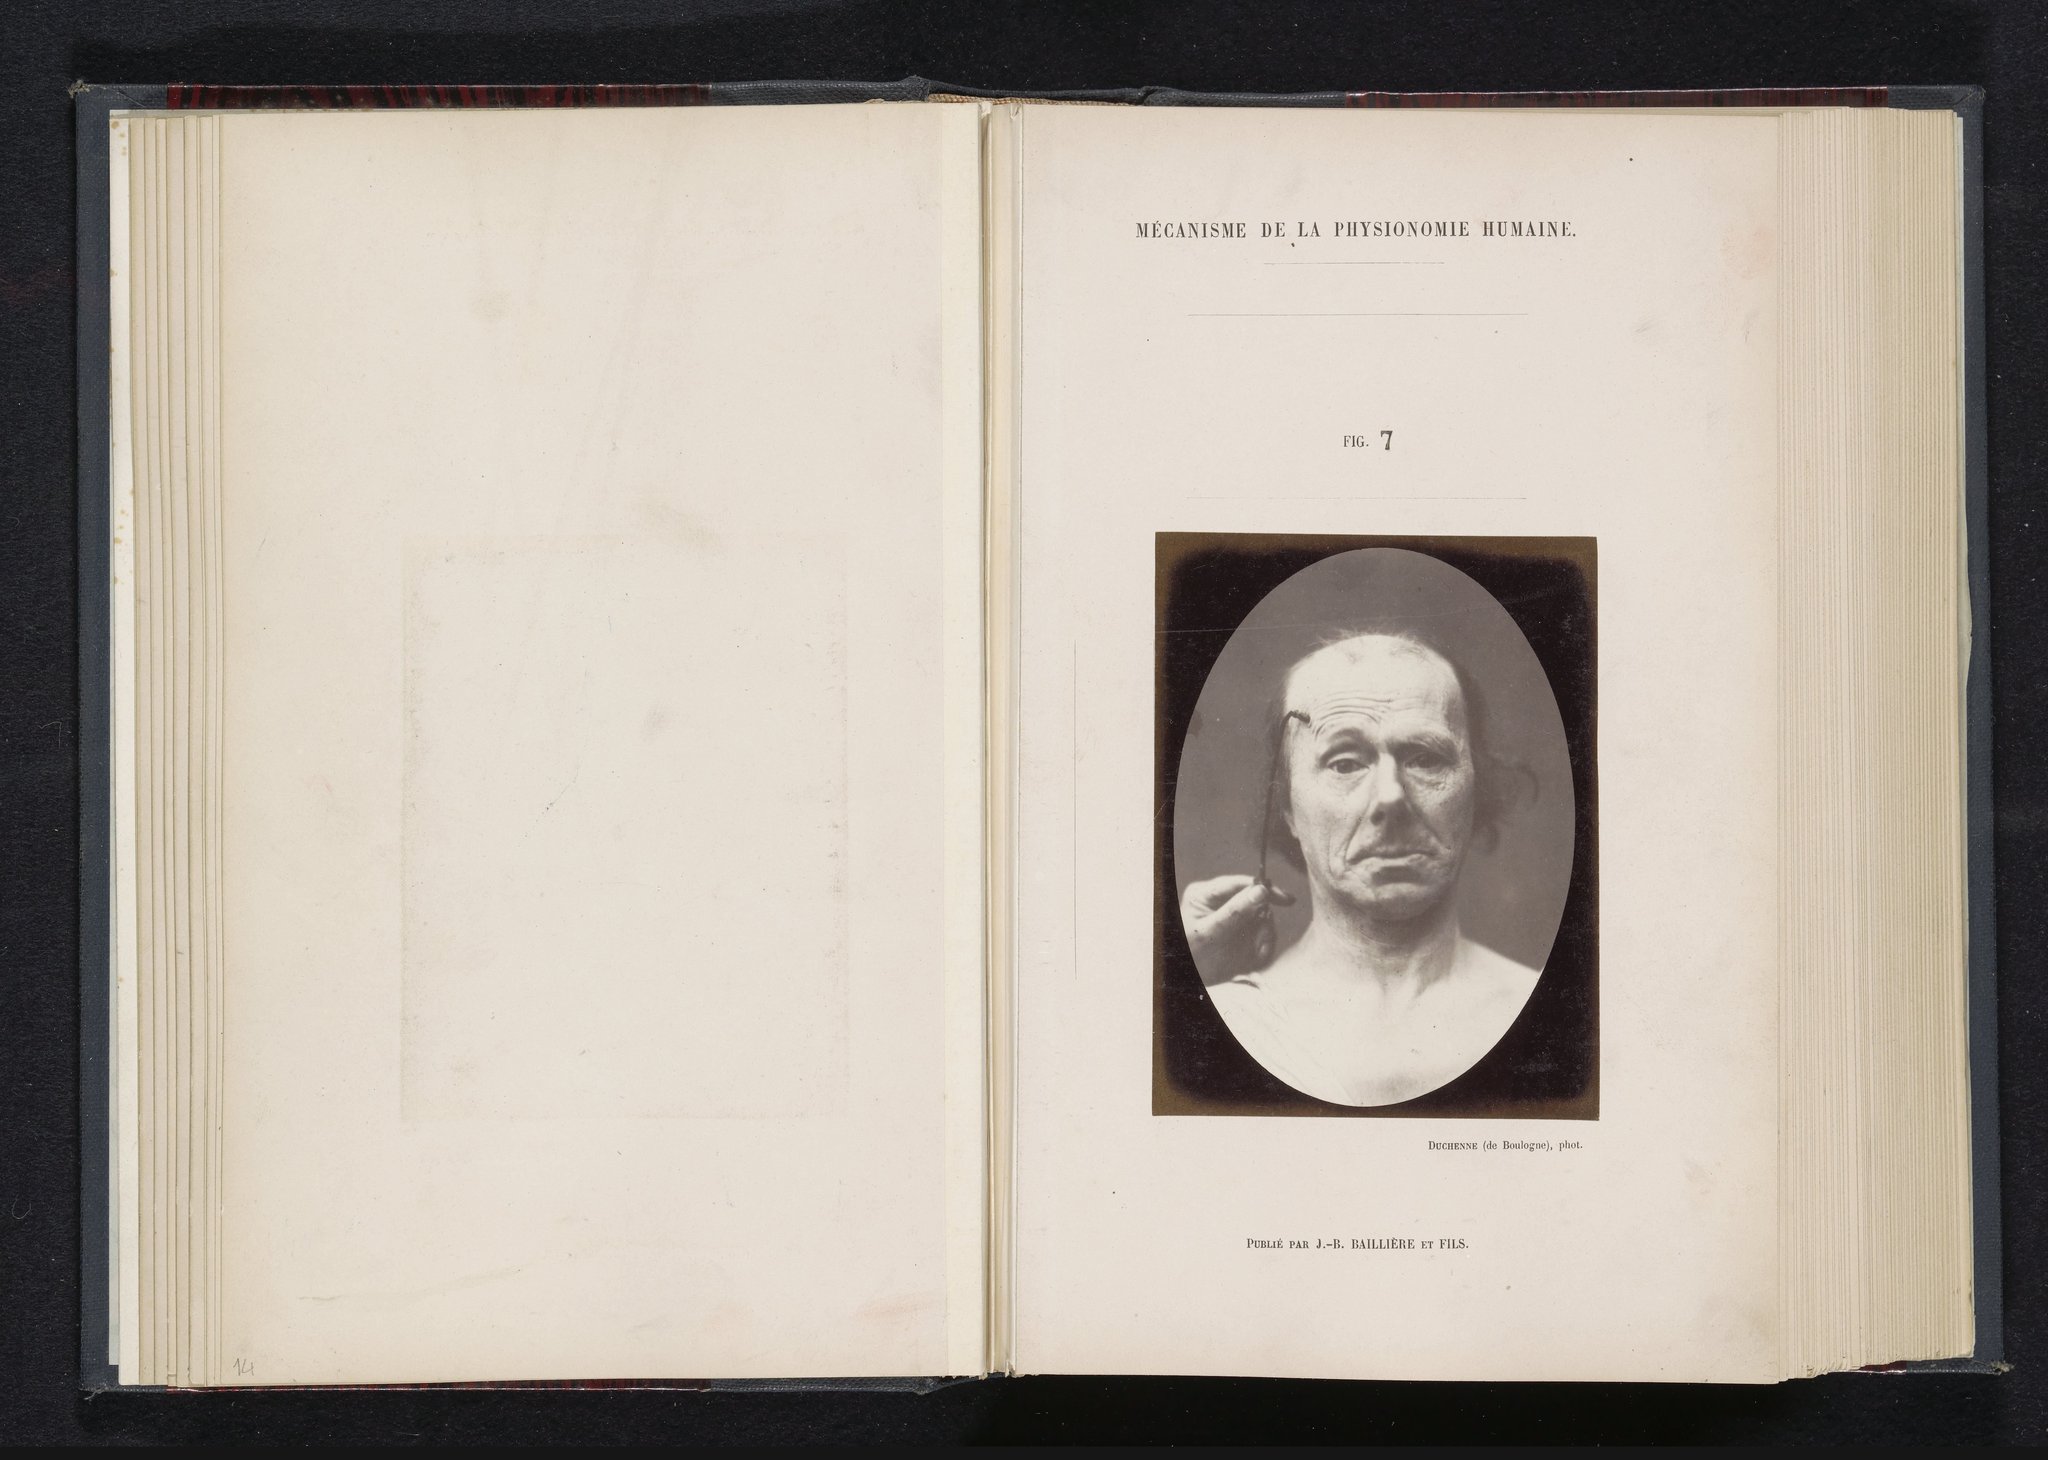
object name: photograph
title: Portret van een proefpersoon tijdens elektrostimulatie: 'un vieillard'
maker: guillaume benjamin amand duchenne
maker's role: fotograaf, medicus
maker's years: 1806-1875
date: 1860-1862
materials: paper, photographic support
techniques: albumen print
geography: paris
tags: face, physiology and anatomy ~ nervous system, neurology, physiology and anatomy, old man, morphology of facial expression, physiognomy, experiment, test ~ science and technology, france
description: Ongenummerde pagina met foto 7 uit Mécanisme de la physionomie humaine ou analyse électro-physiologique de l'expression des passions (Atlas).